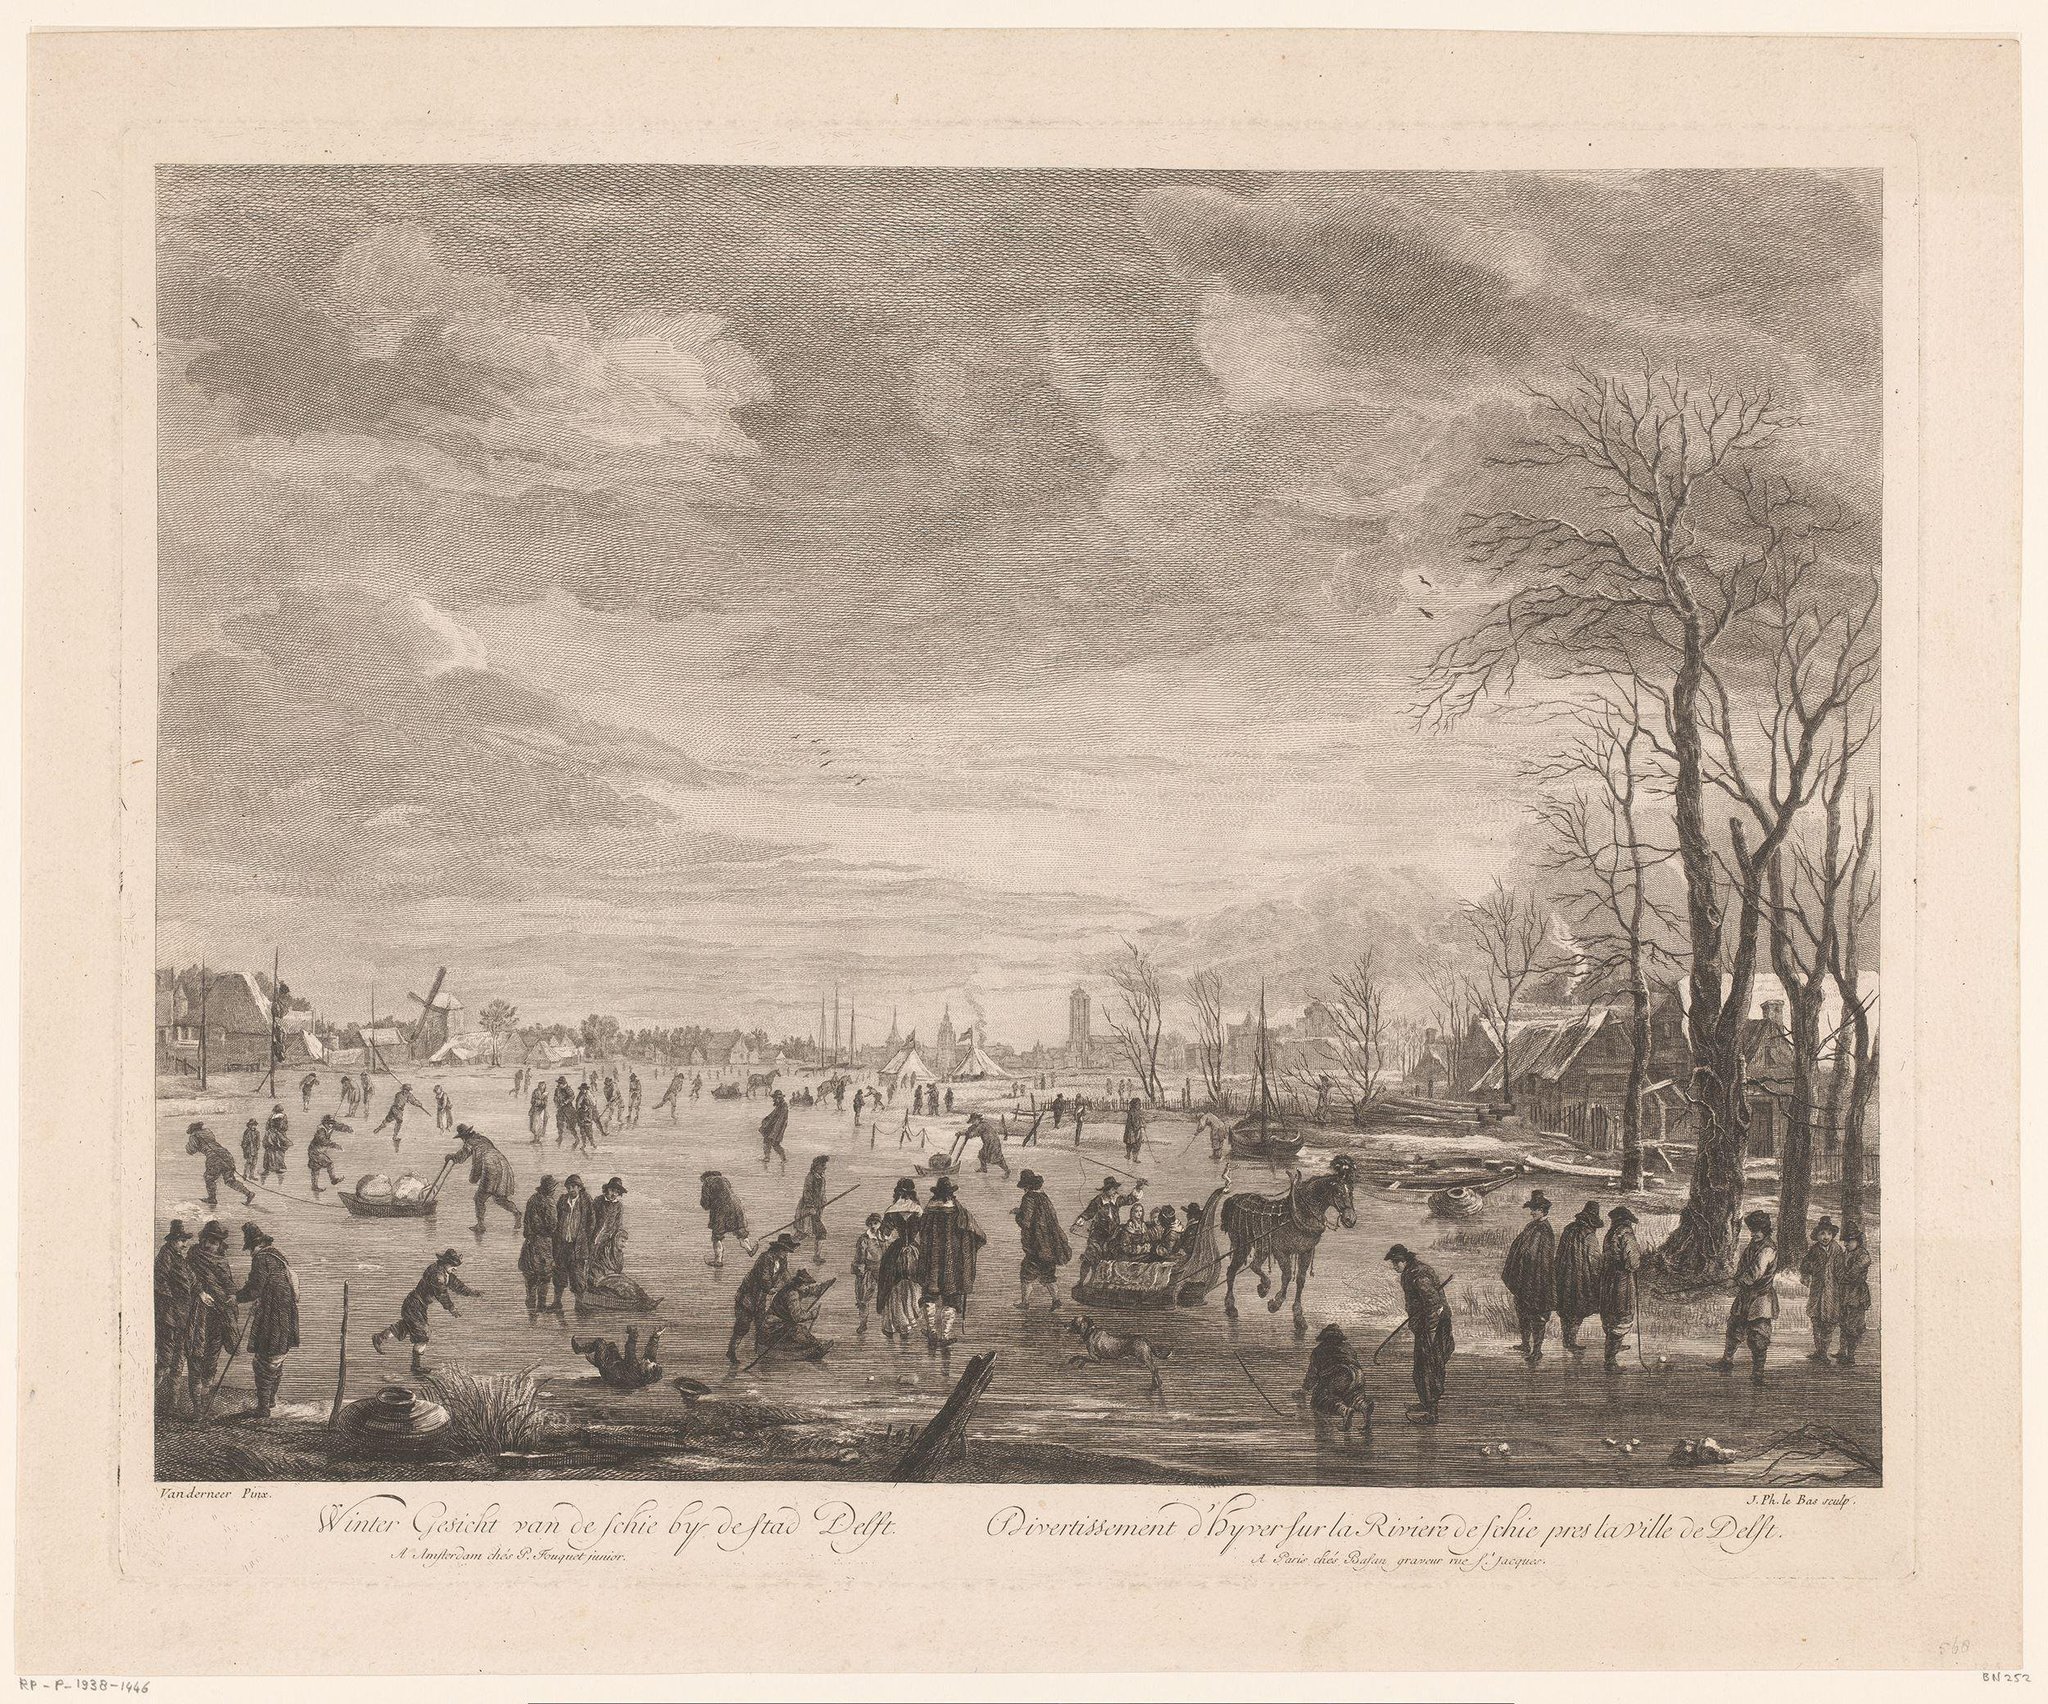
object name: print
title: Gezicht op Delft vanaf de bevroren Schie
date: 1717-1783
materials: paper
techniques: engraving, etching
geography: paris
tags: city-view, and landscape with man-made constructions, skates (winter sports), delft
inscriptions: collector's mark: Lugt 2228